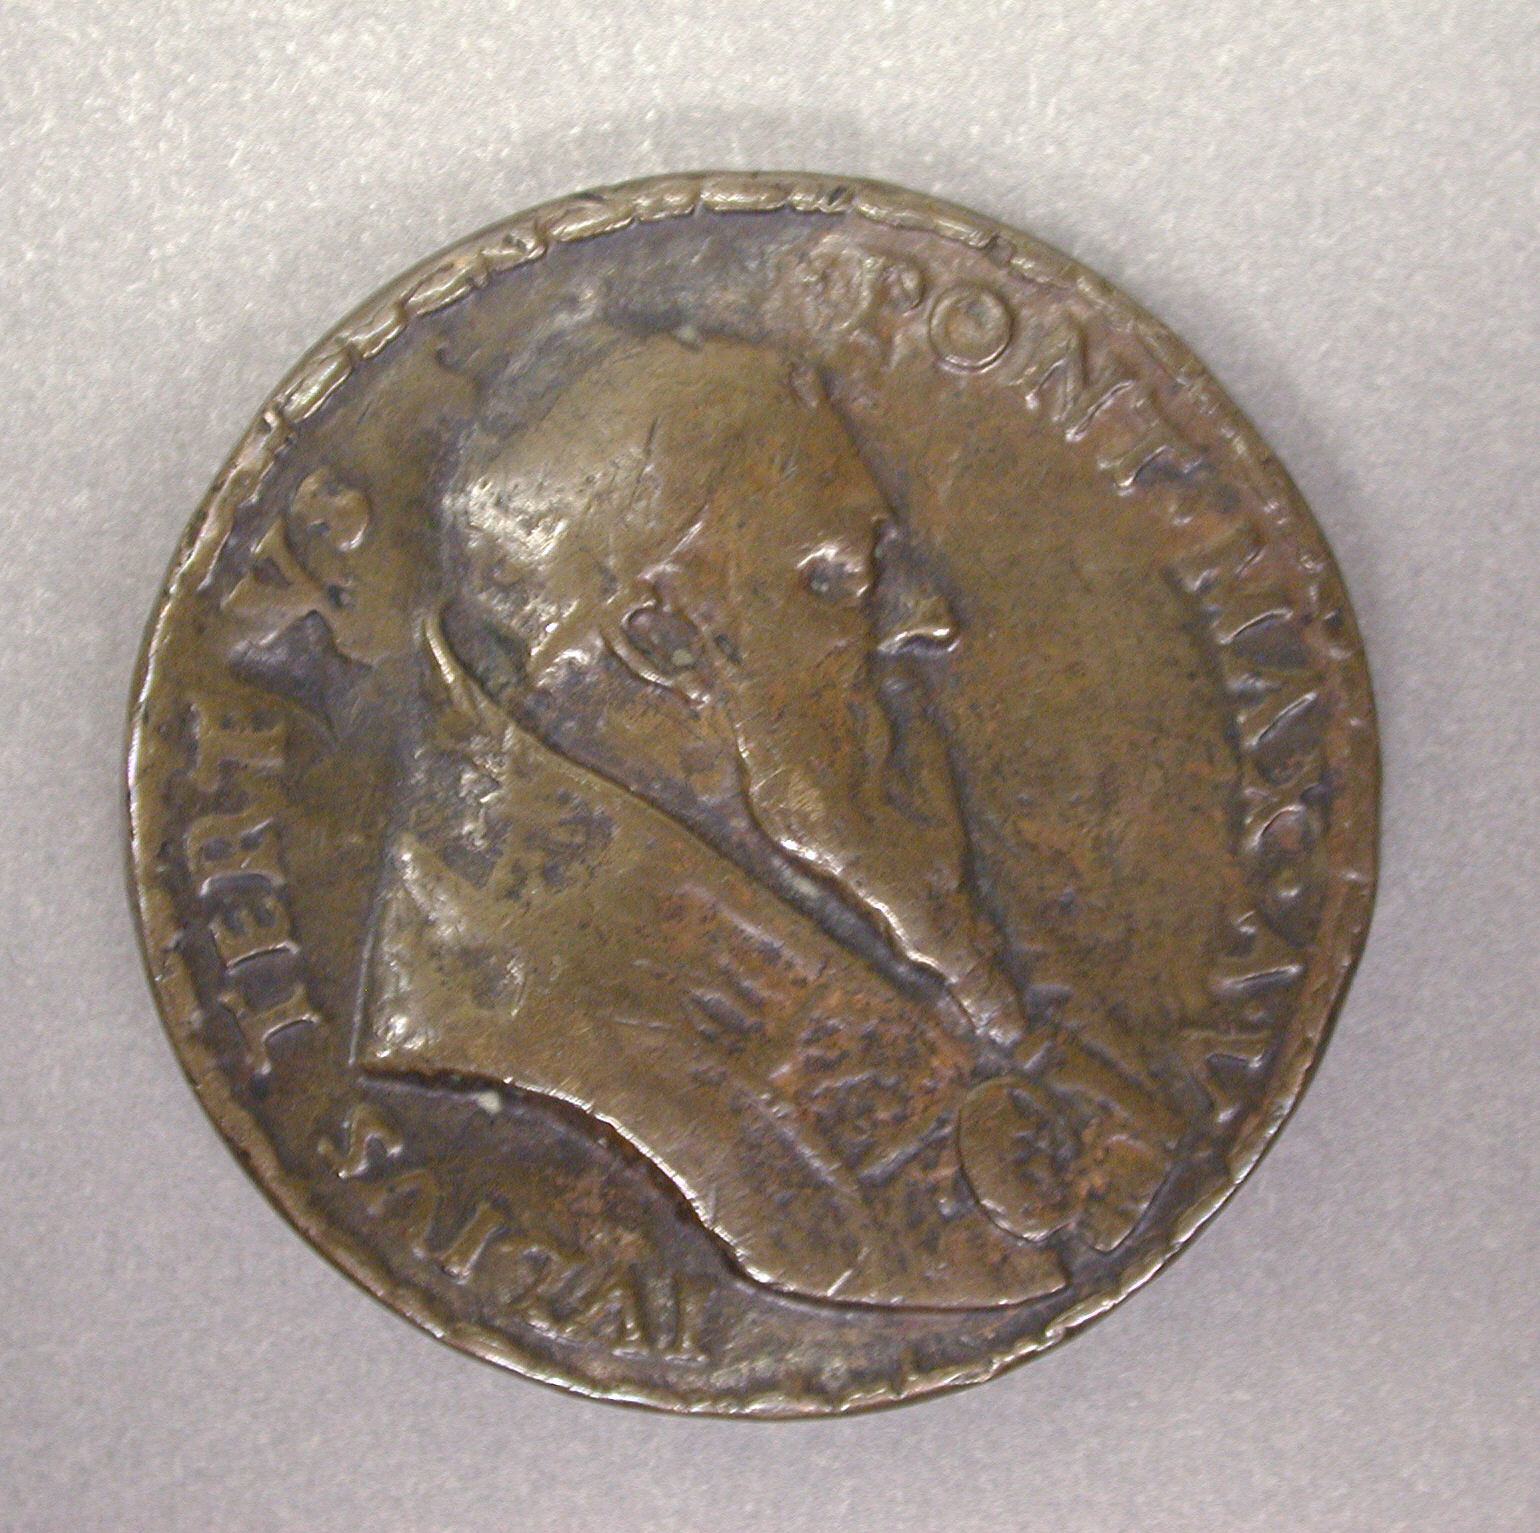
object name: medal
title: Restoration of Popery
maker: giovanni del cavino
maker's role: maker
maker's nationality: italian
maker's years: 1500-1570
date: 1554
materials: bronze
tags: human figures,men,profiles